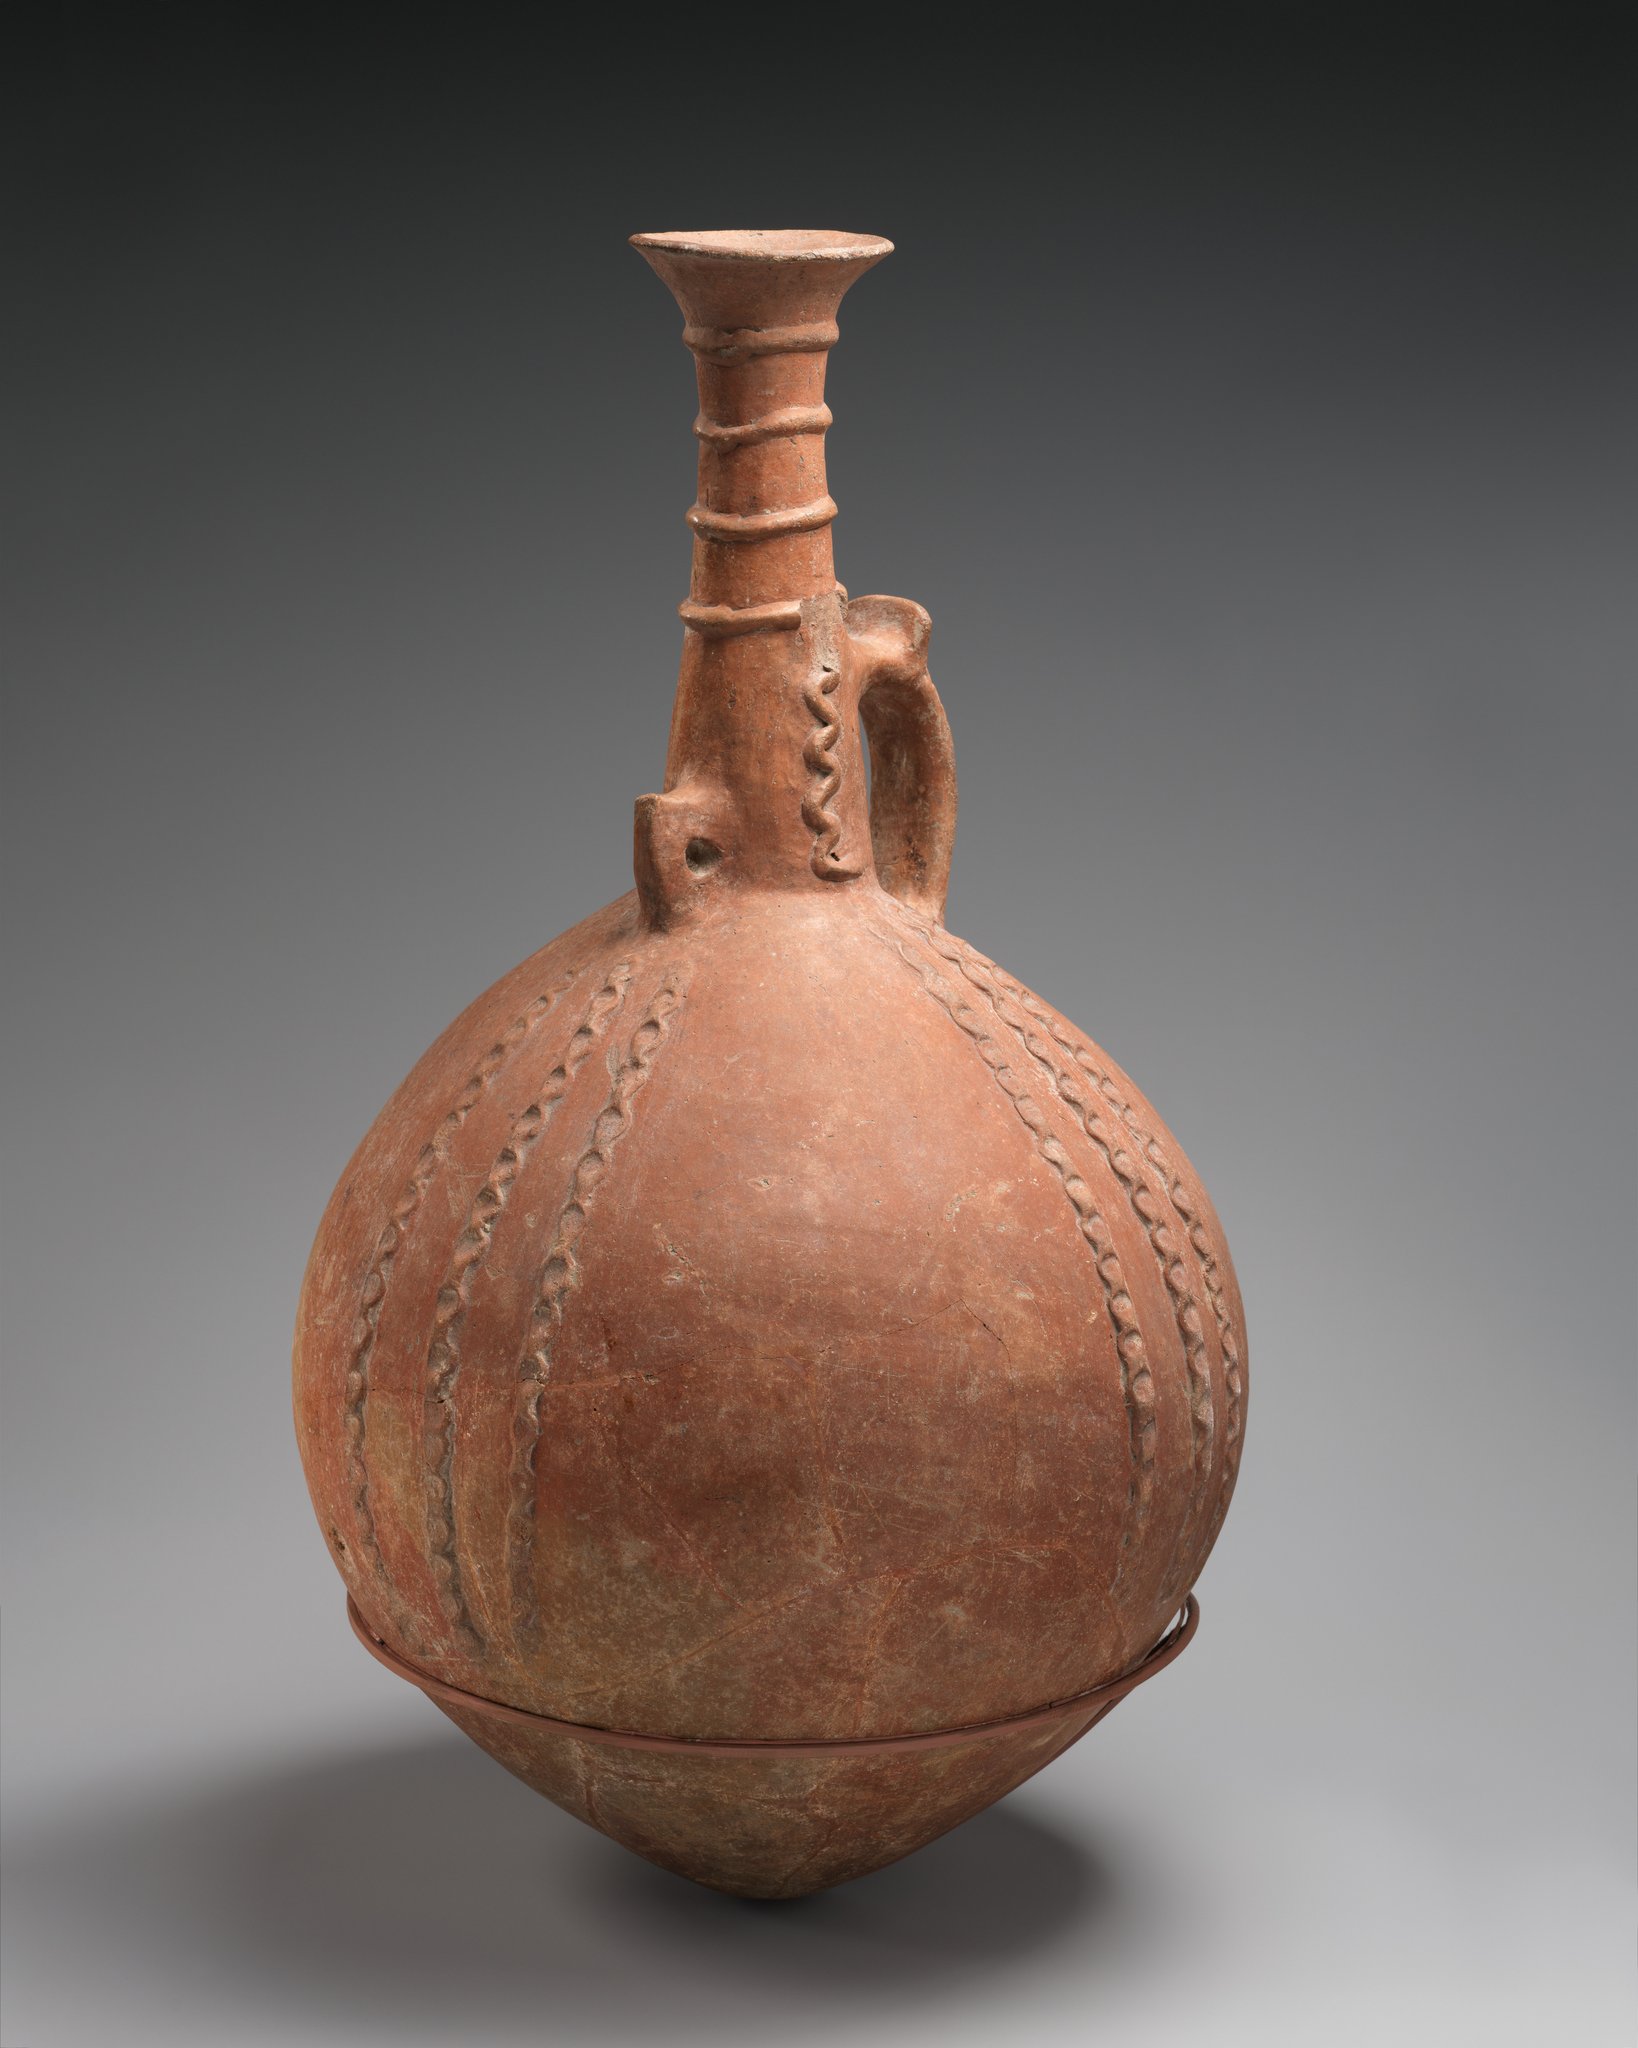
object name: jug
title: Terracotta jug with relief ornament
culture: cypriot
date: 2500-1900 BCE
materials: terracotta